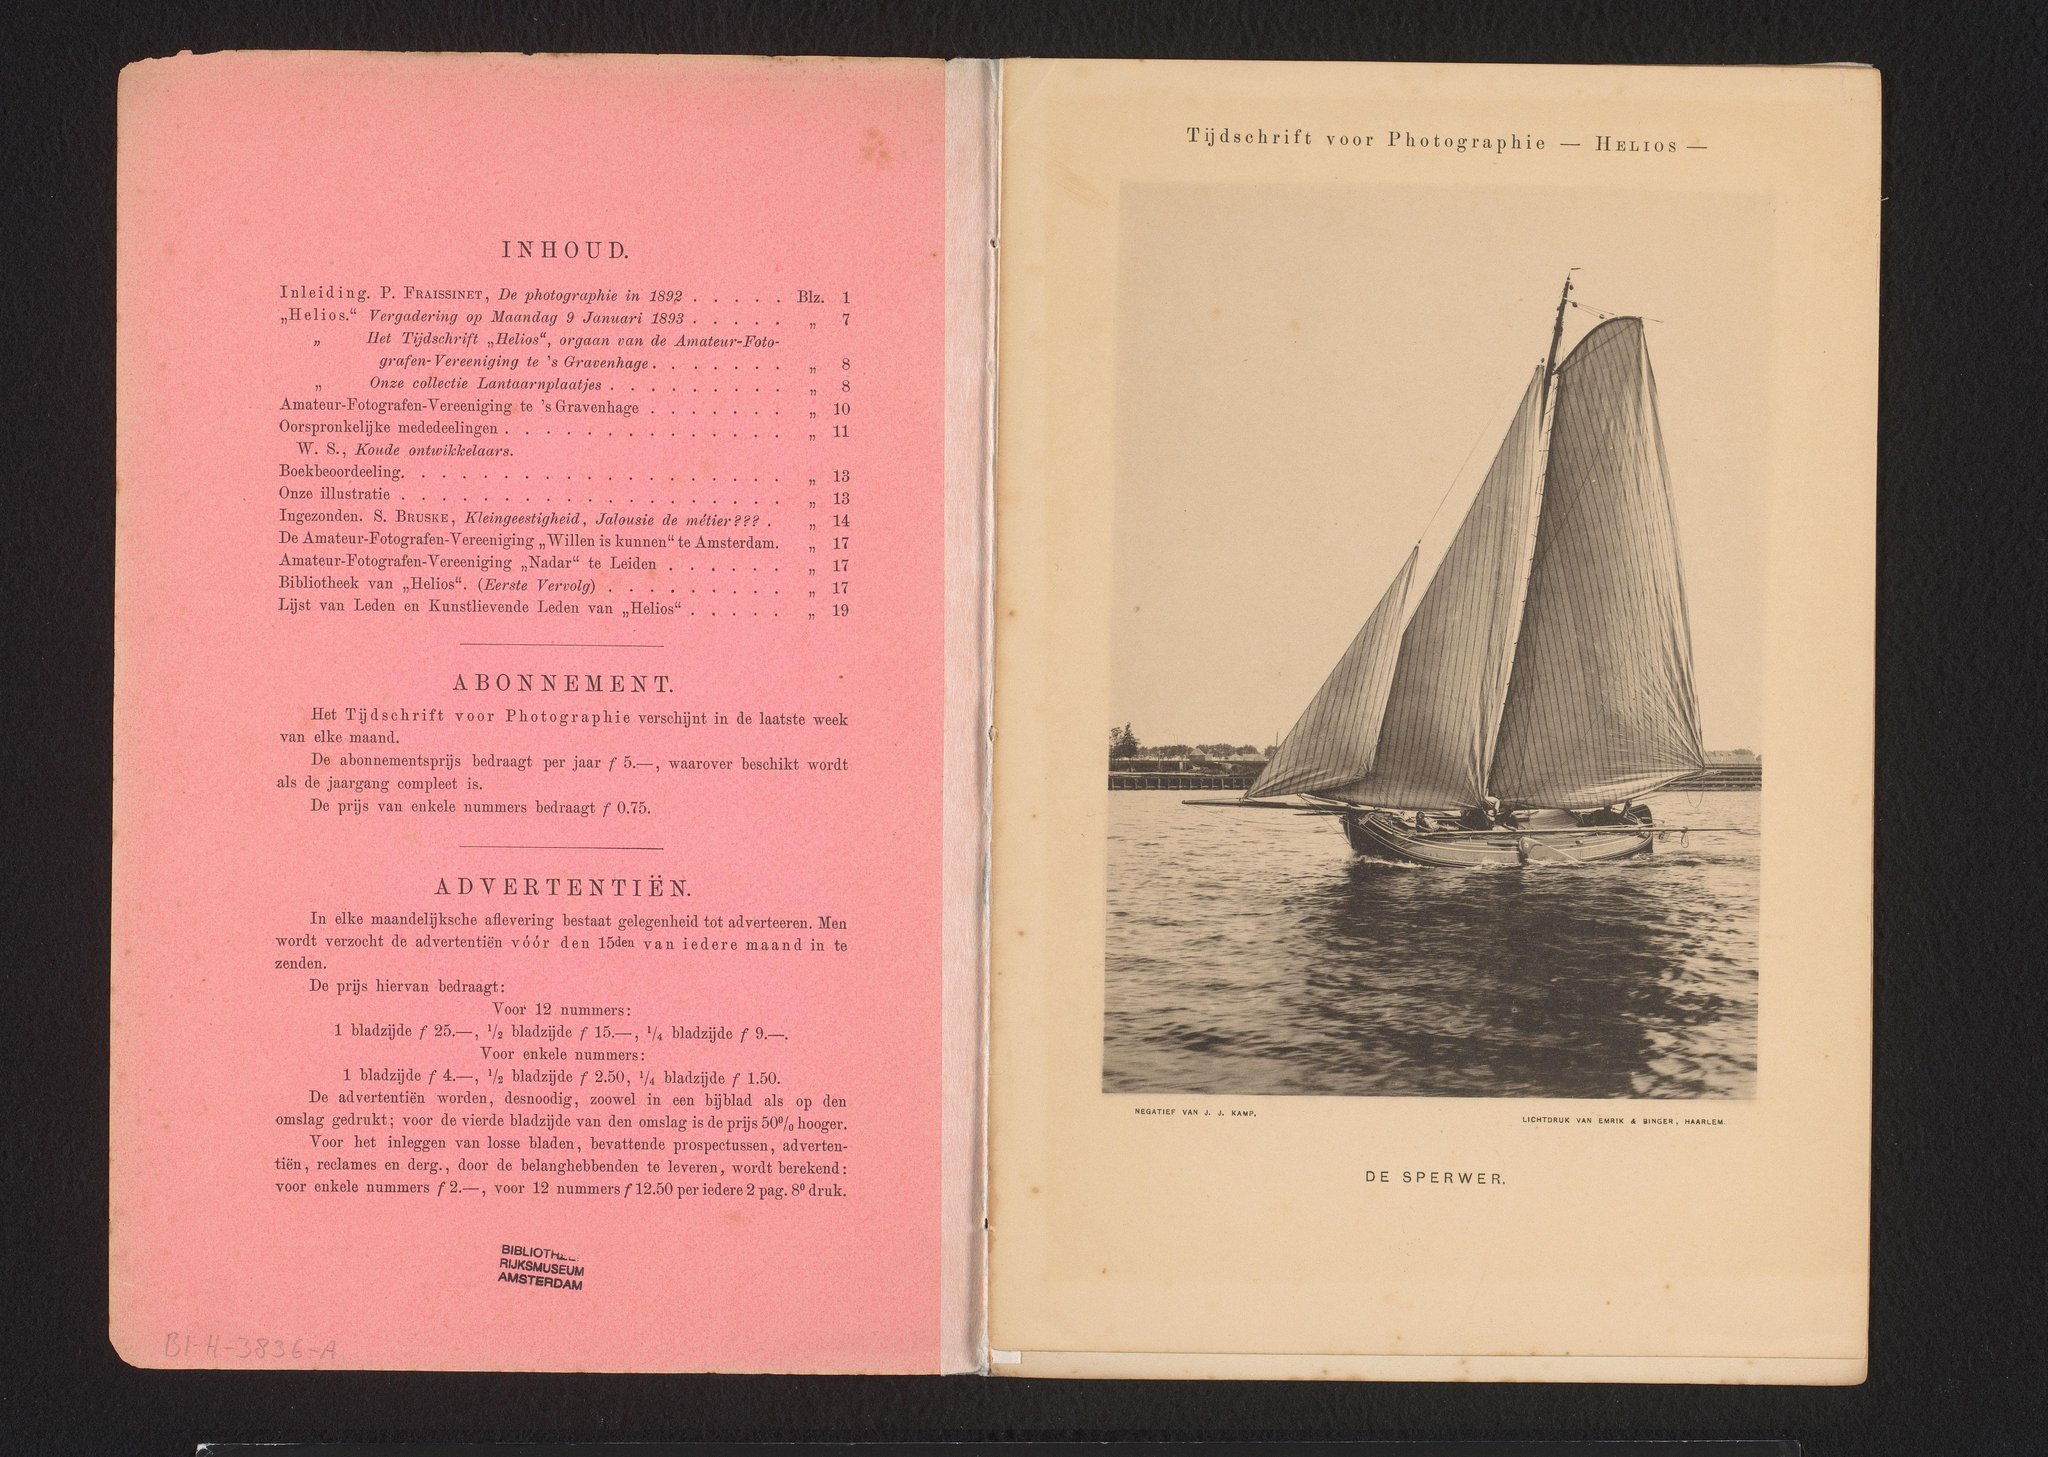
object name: photomechanical print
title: Boeier 'De Sperwer' te water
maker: j.j. kamp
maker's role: fotograaf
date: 1888-1893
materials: paper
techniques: photograph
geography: haarlem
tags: sailing-ship, sailing-boat